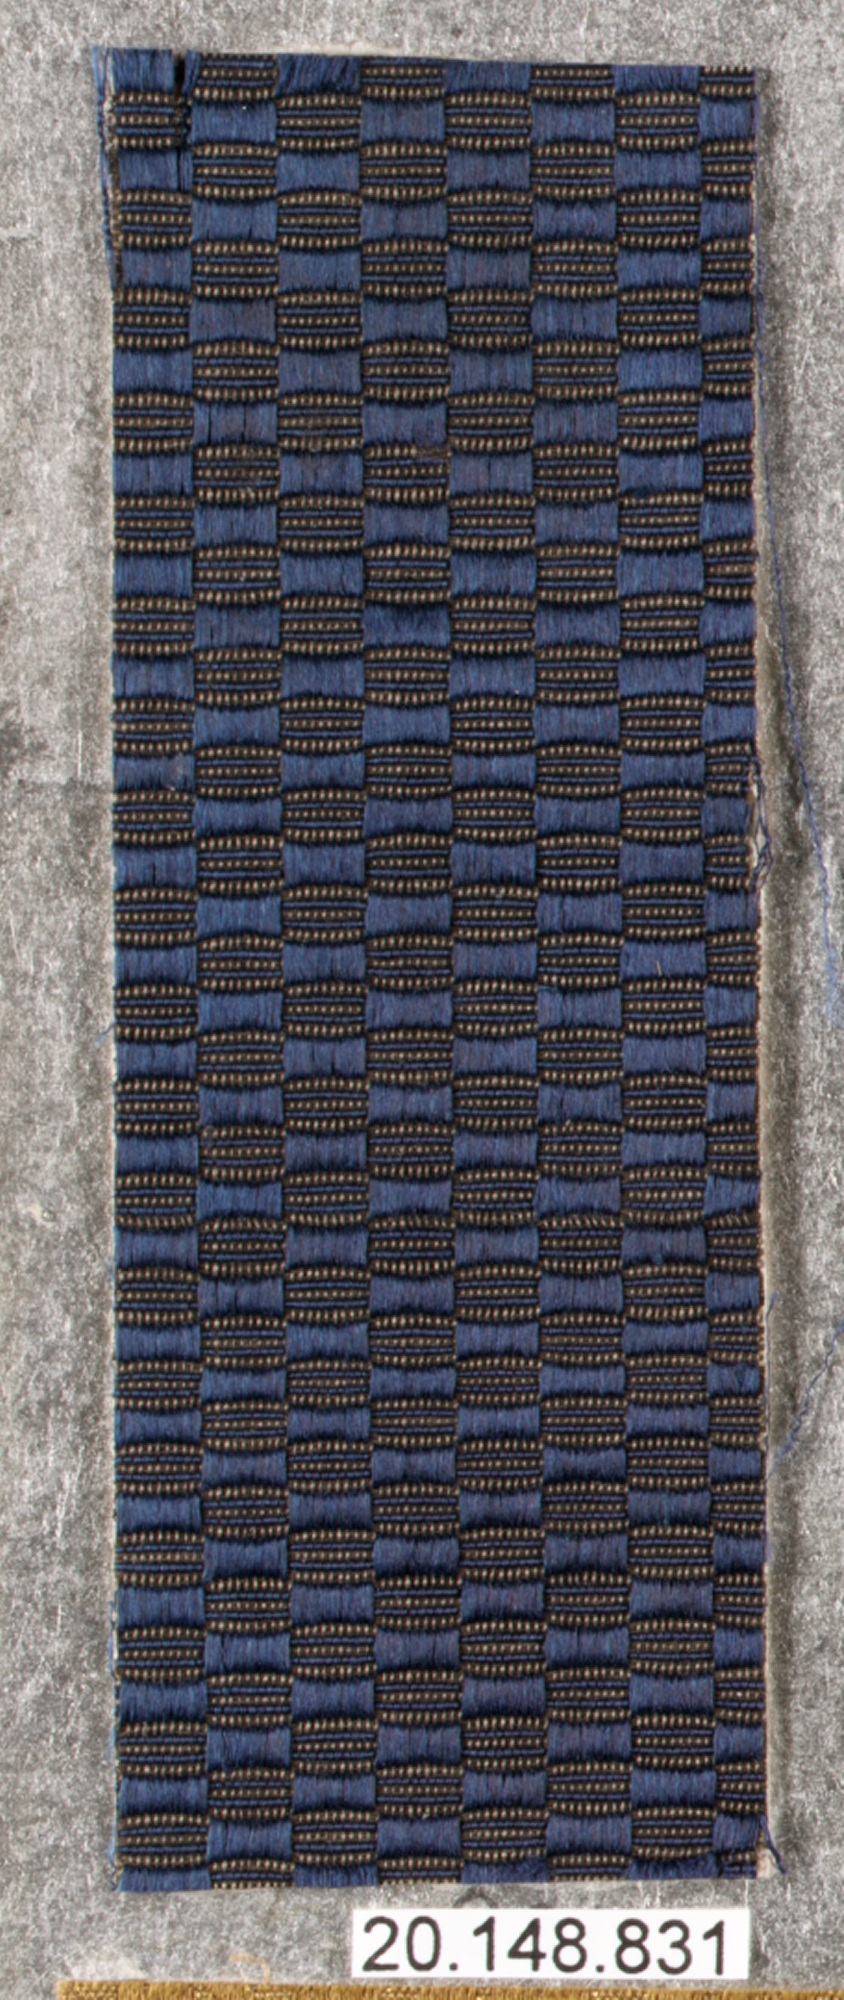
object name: piece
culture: japanese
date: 1701-1800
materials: silk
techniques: compound weave